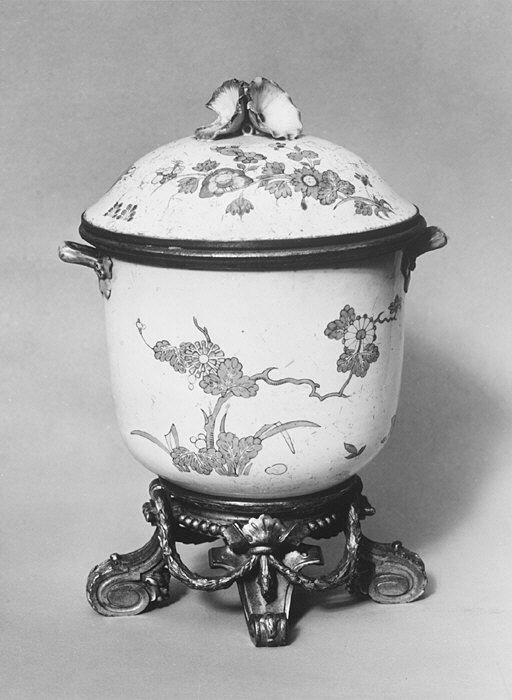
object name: bowl with cover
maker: chantilly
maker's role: factory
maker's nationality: french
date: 1735-1740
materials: gilt bronze, soft paste porcelain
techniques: glazing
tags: flowers